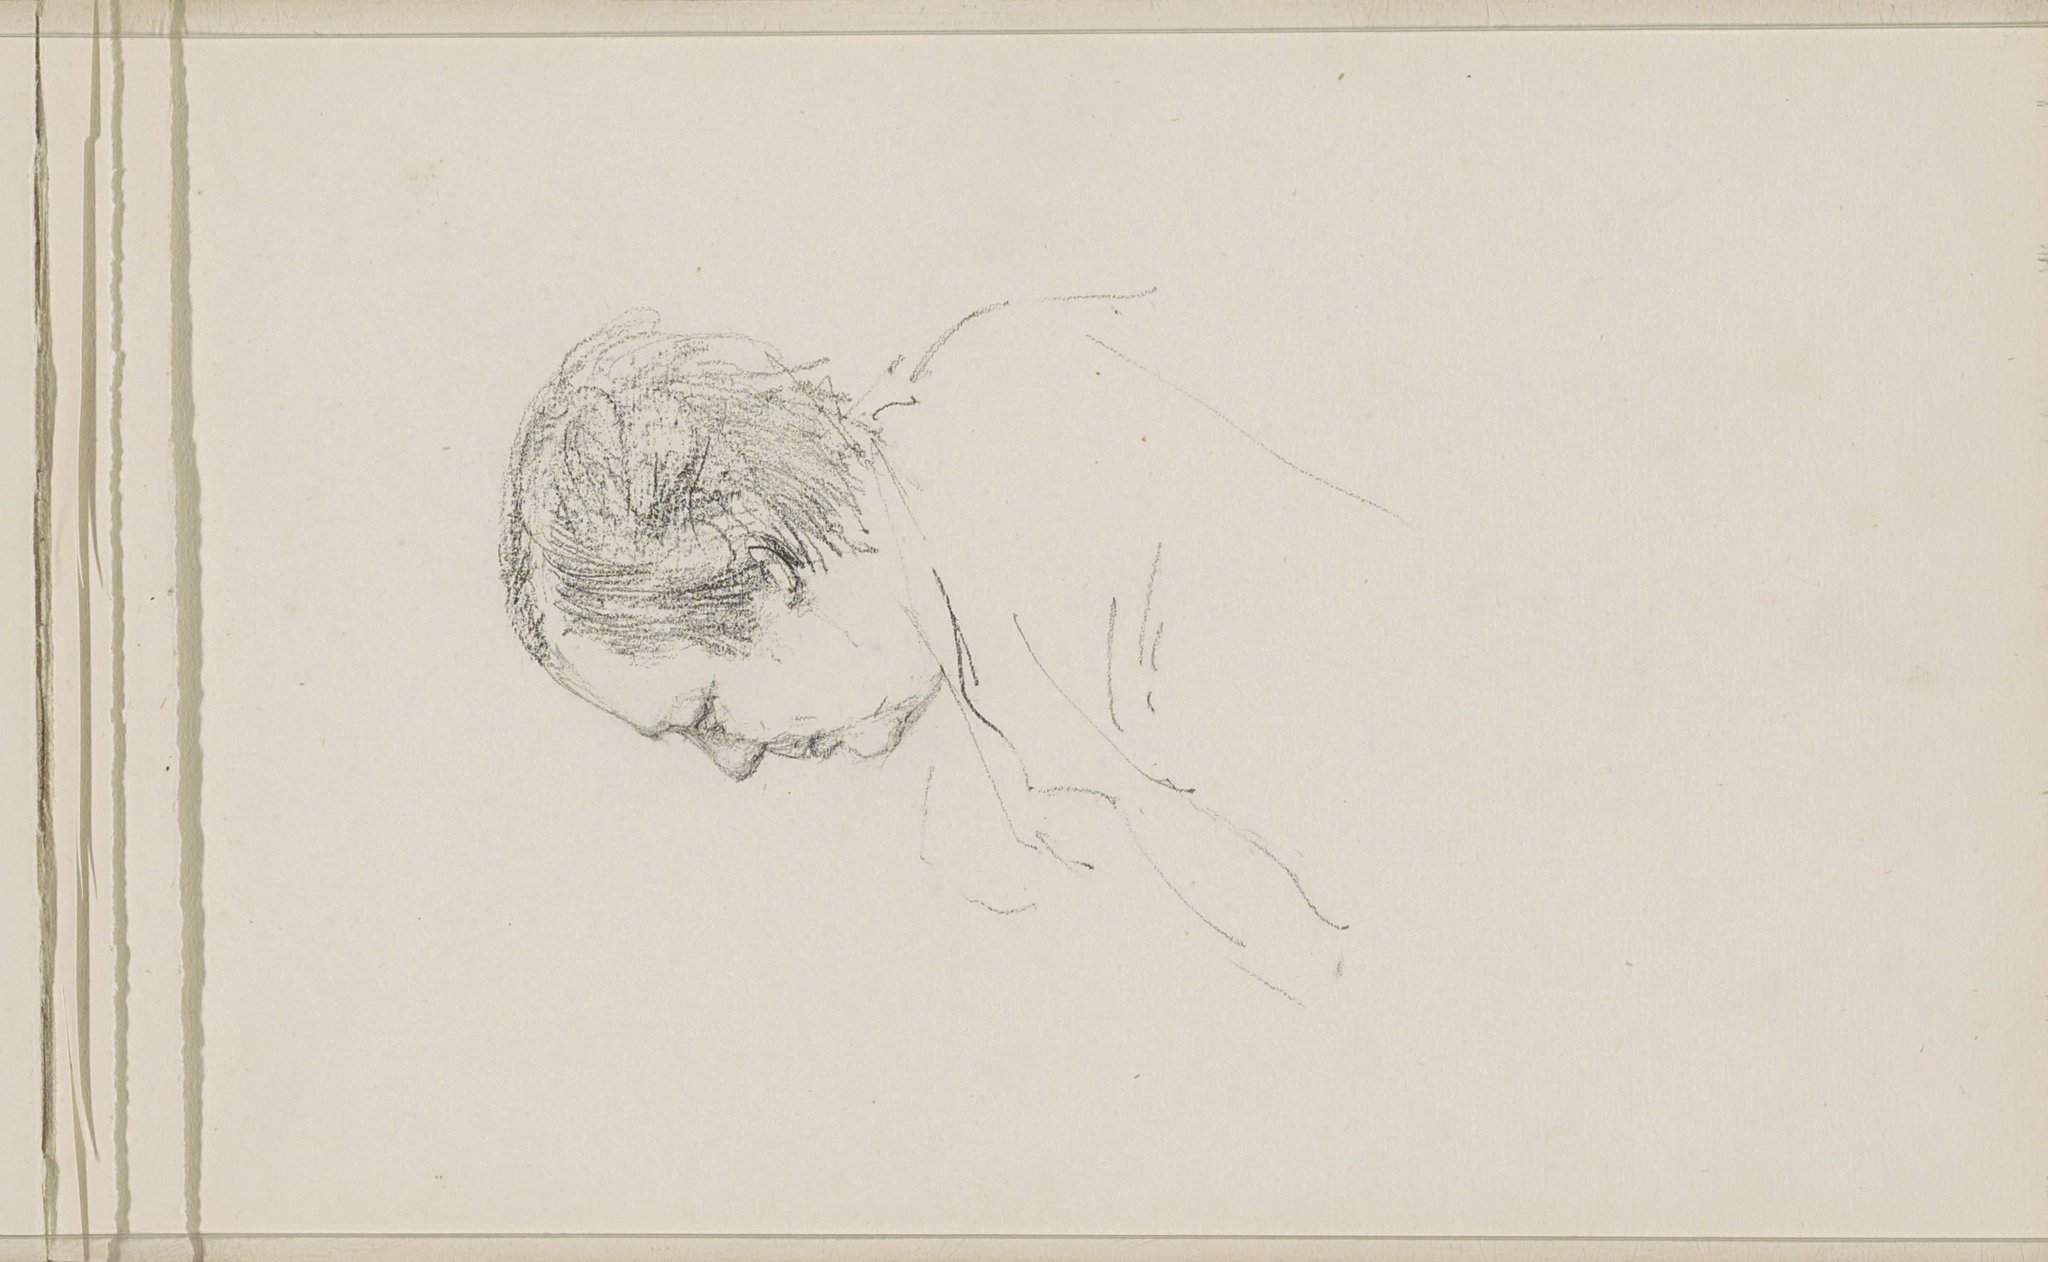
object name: sketchbook leaf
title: Kop van een man, in profiel naar links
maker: a.a.l. de grammont-hubrecht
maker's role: draughtsman, painter, print maker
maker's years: 1855-1913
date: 1865-1913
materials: chalk, paper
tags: head (human), adult man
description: Blad 4 recto uit een schetsboek met 28 bladen.